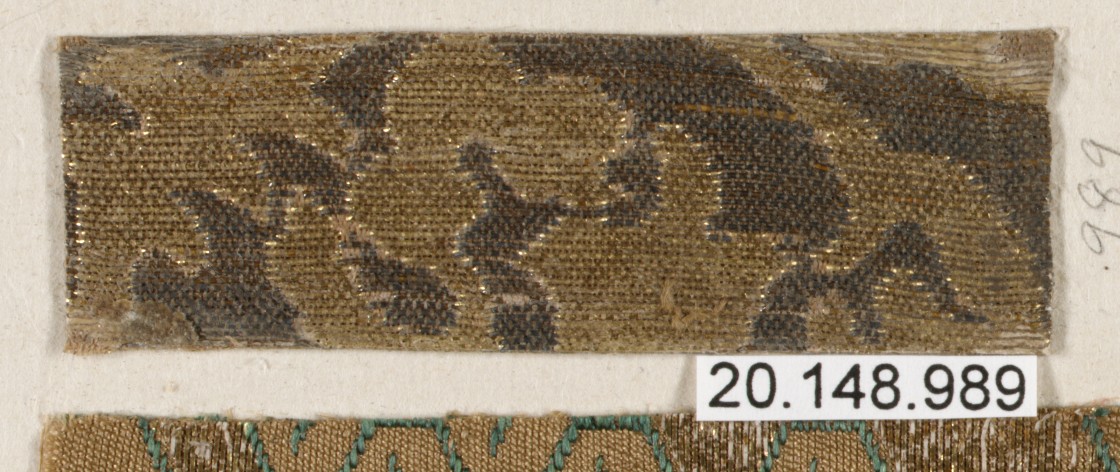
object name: piece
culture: japanese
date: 1601-1700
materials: silk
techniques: compound weave